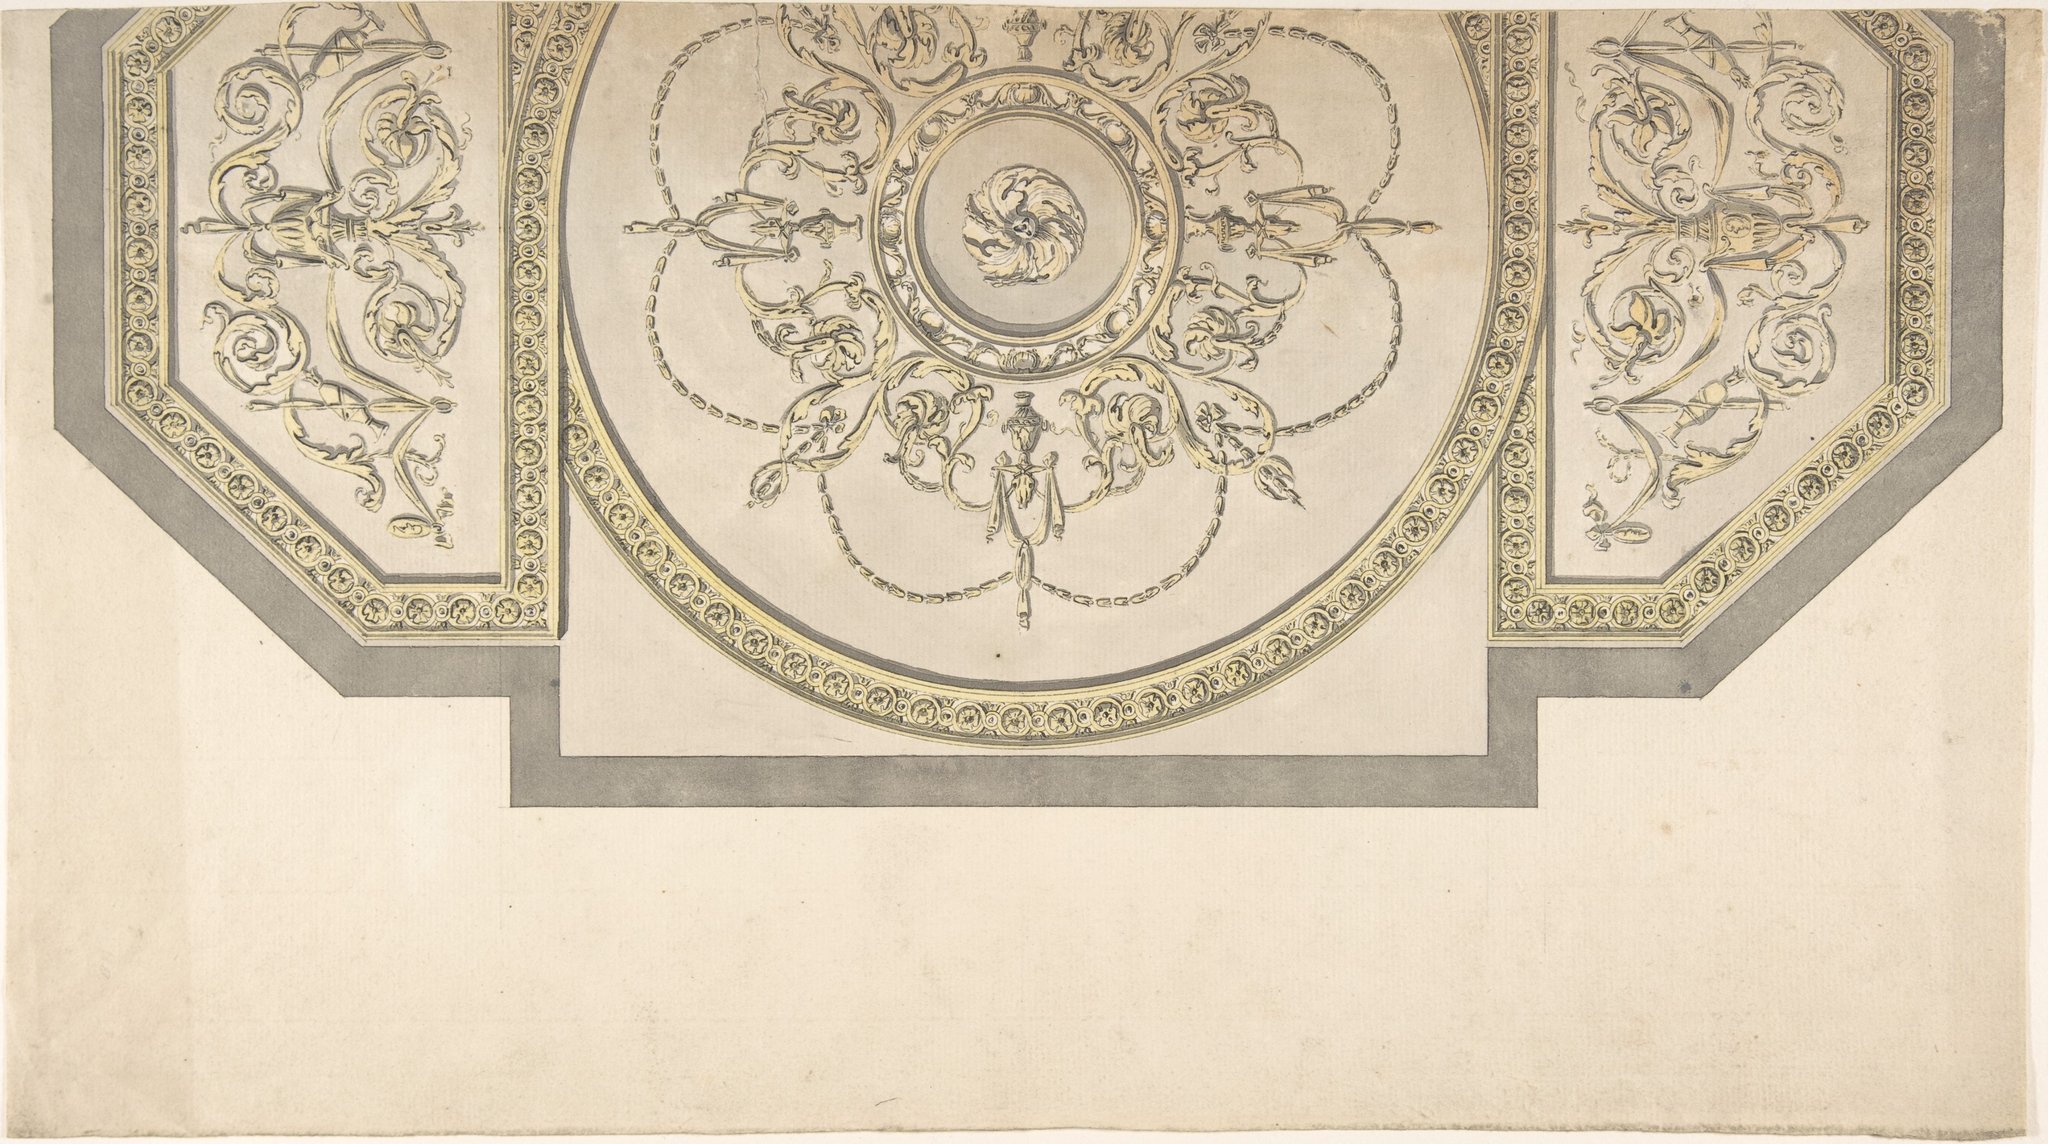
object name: drawing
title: Design for the Gallery ceiling, Richmond House, Whitehall, London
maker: sir william chambers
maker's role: artist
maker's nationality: british, born sweden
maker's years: 1723-1796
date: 1760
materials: ink, watercolor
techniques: brush, pen, wash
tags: ornament